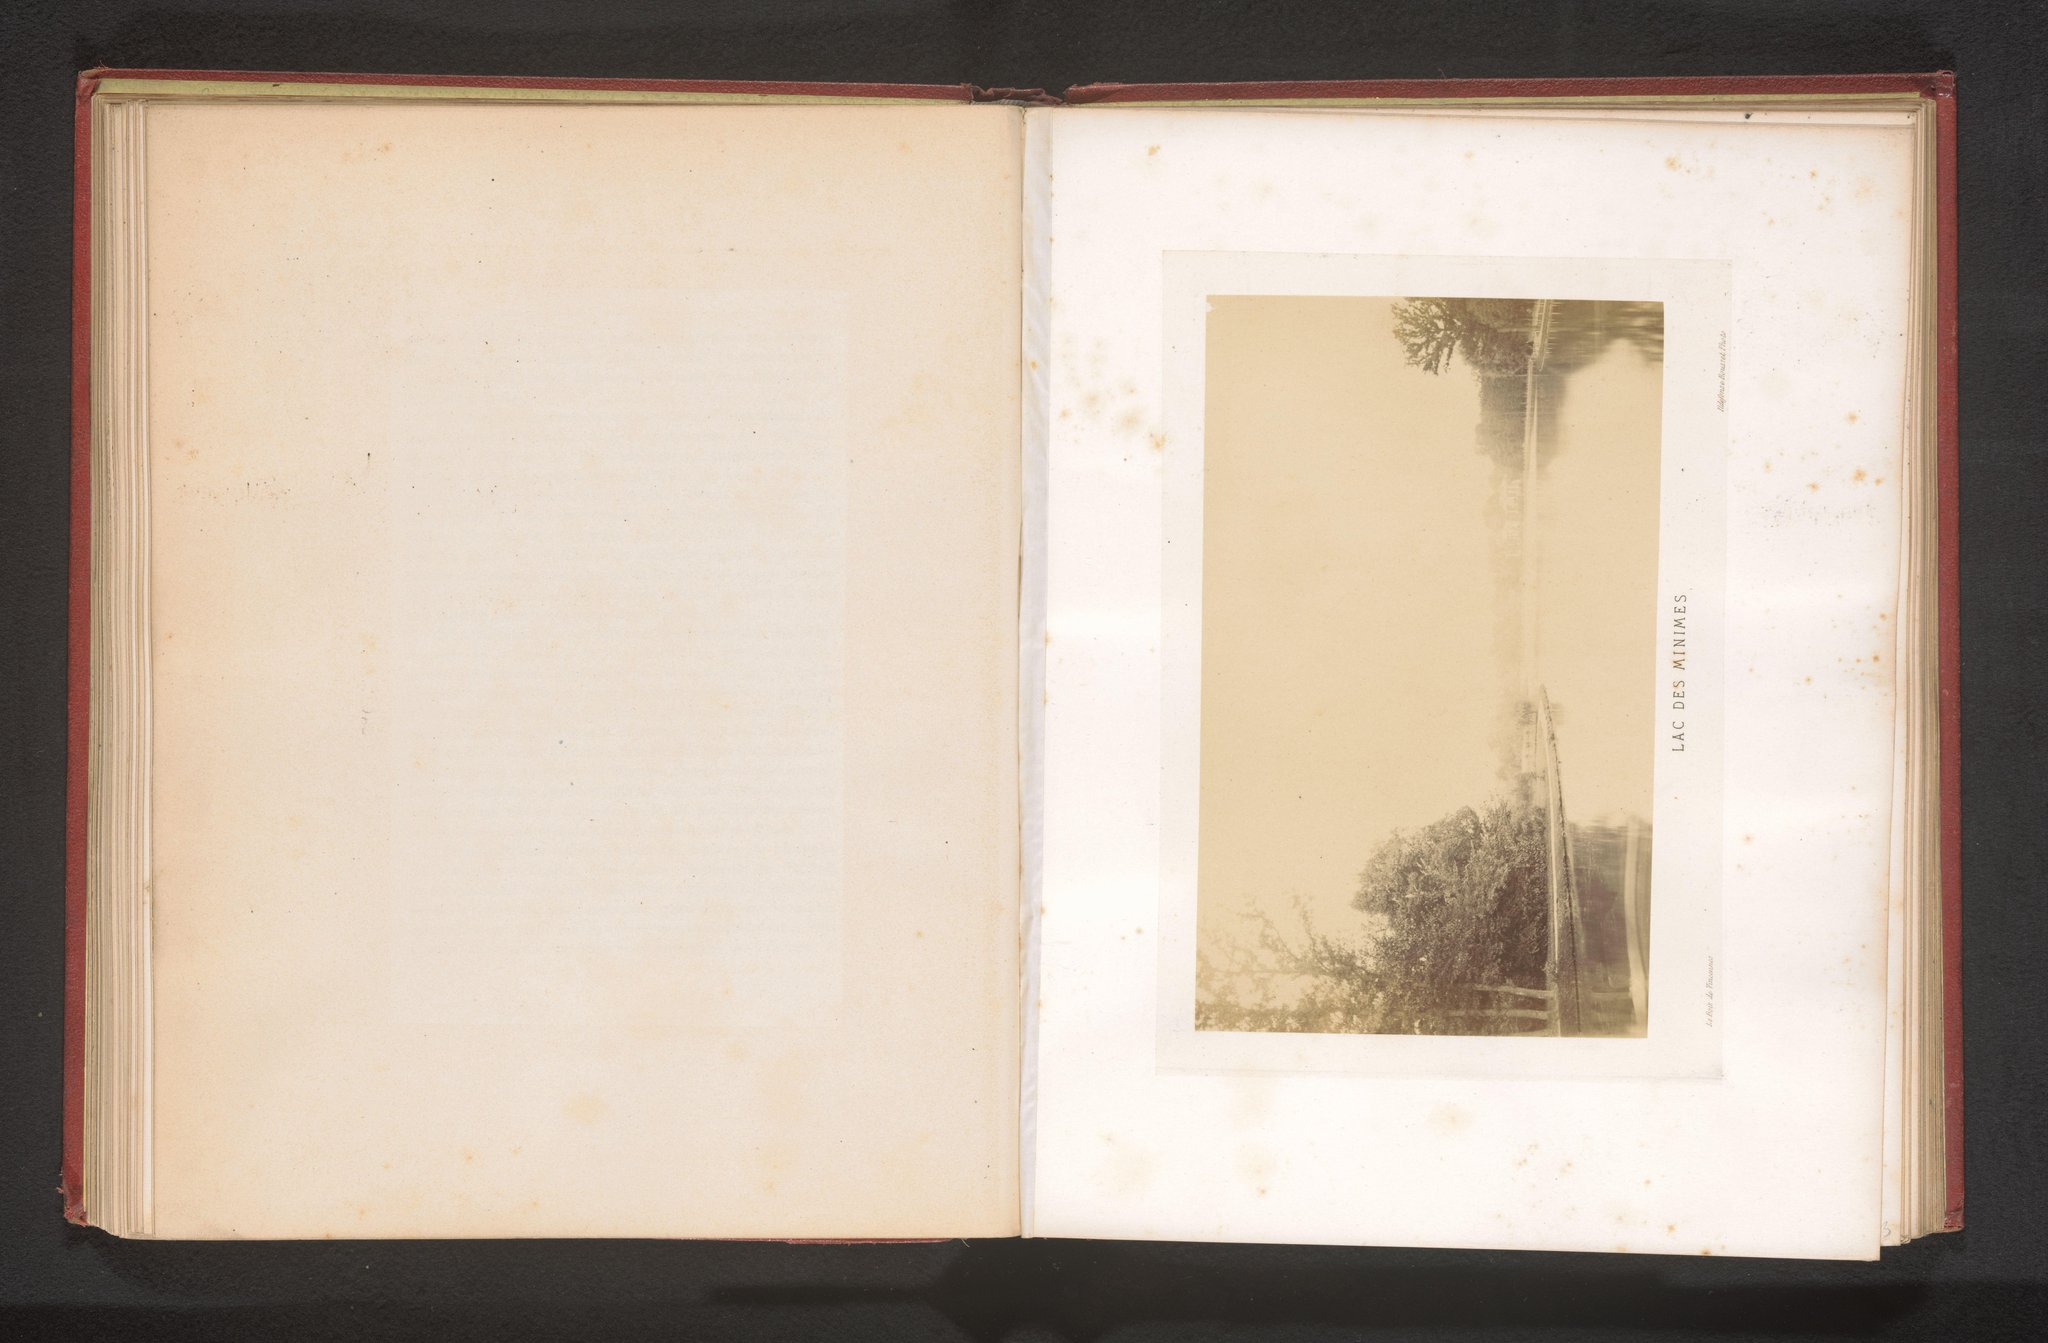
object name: photograph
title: Bois de Vincennes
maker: ildefonse rousset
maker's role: fotograaf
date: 1861-1866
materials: photographic support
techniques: albumen print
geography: bois de vincennes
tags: lake, public gardens, park